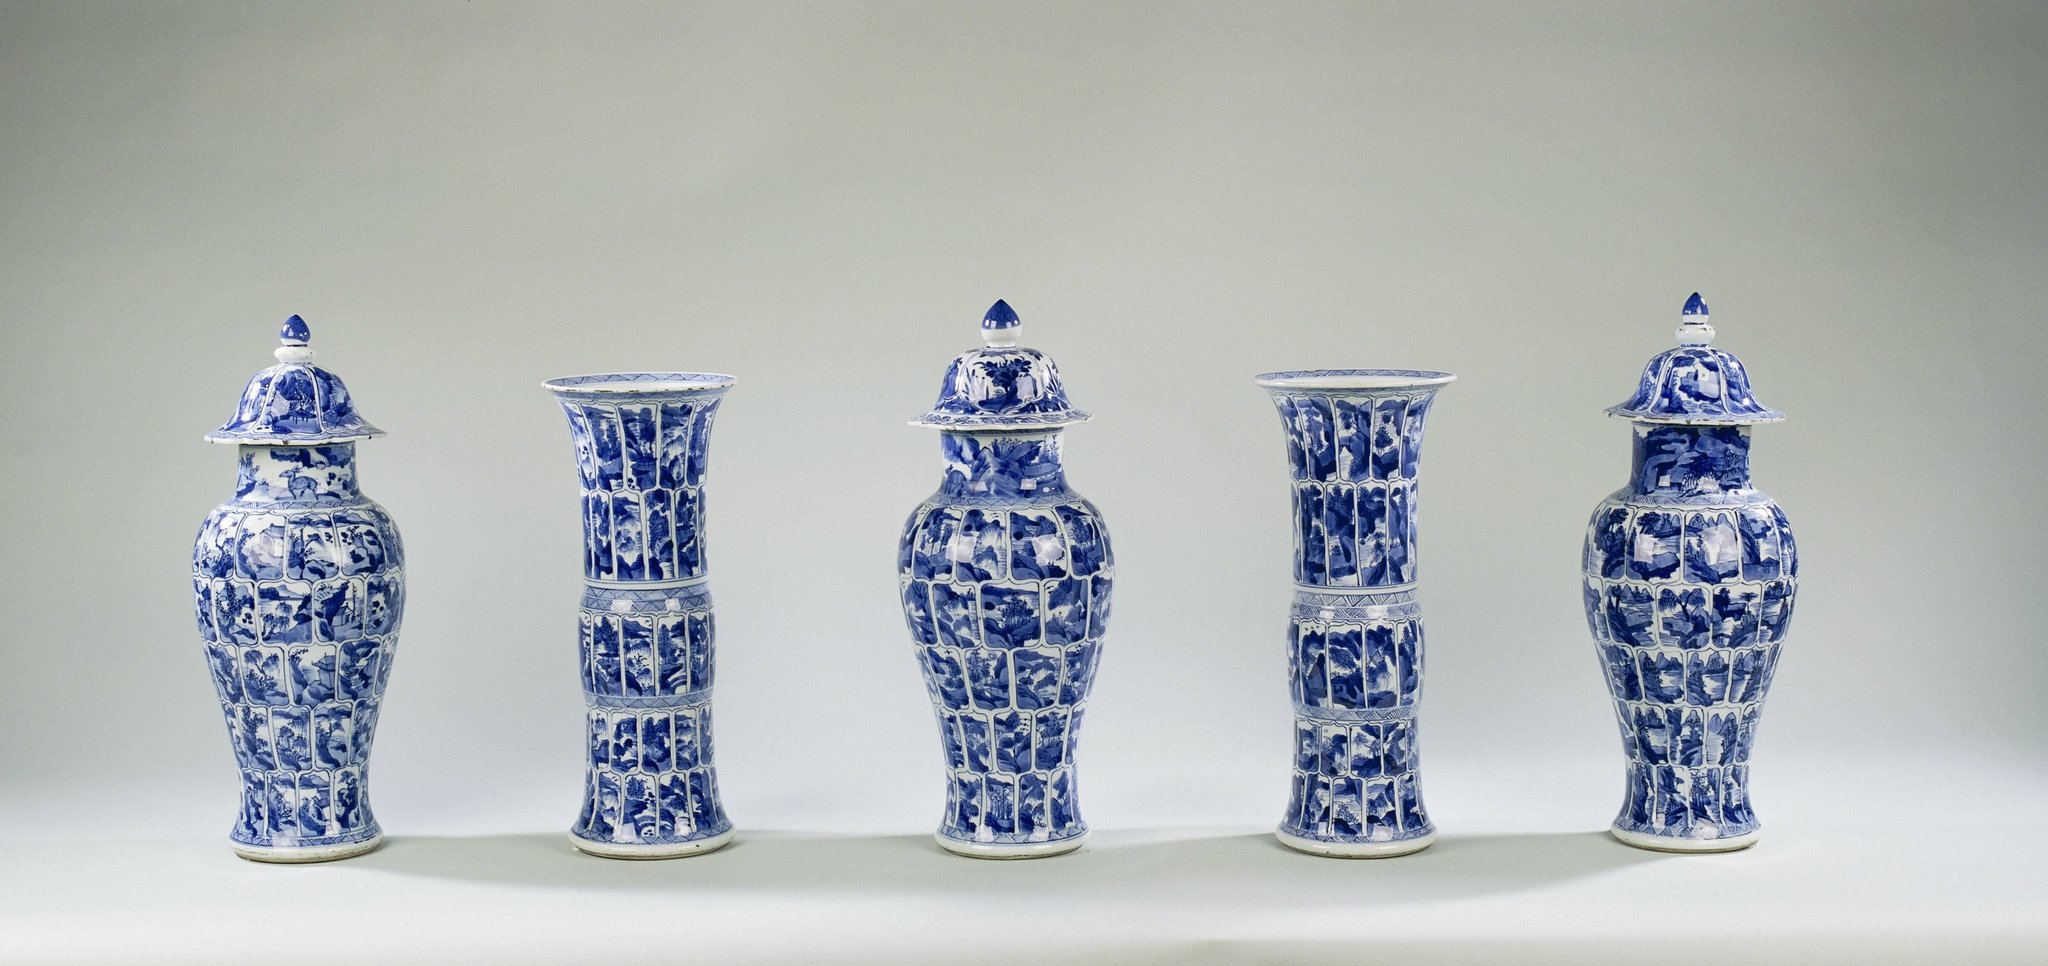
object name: kaststel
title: Five-piece garniture with landscapes in panels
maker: Anonymous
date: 1700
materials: cobalt, glaze, paint, porcelain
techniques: firing, turning, vitrification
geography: china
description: Vijfdelig kaststel van porselein bestaande uit twee bekervazen en drie dekselvazen. Beschilderd in onderglazuur blauw met landschappen in lotusvormige cartouches. Blauw-wit.